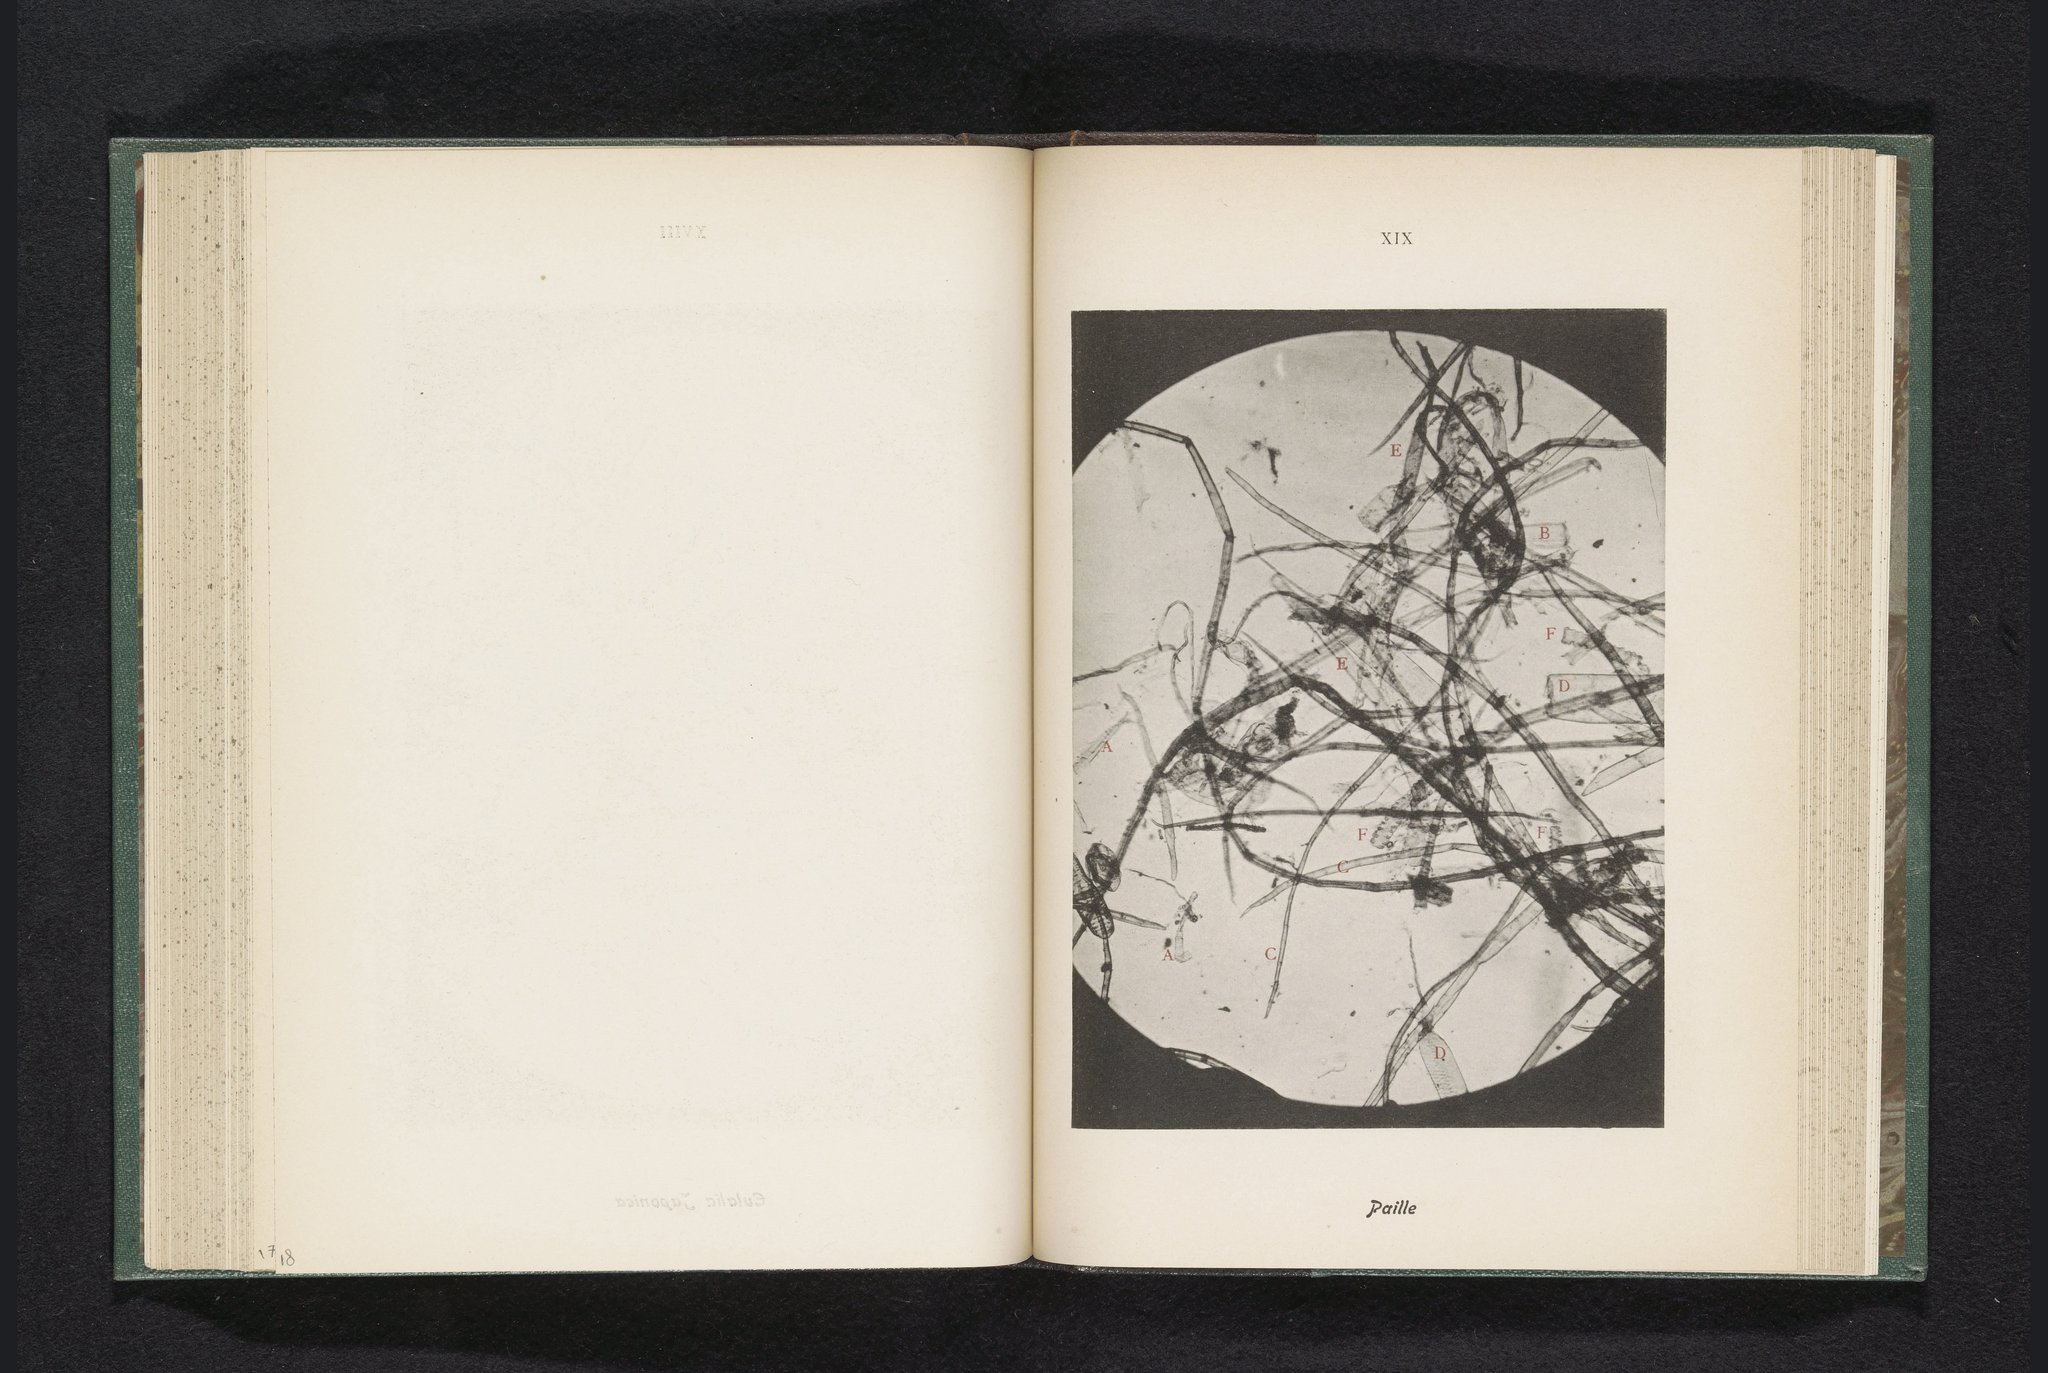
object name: page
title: Micro-opname van strovezel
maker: Anonymous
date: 1890-1900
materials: paper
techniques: photograph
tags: agricultural products and by-products: straw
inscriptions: number: ‘XIX’, inscription